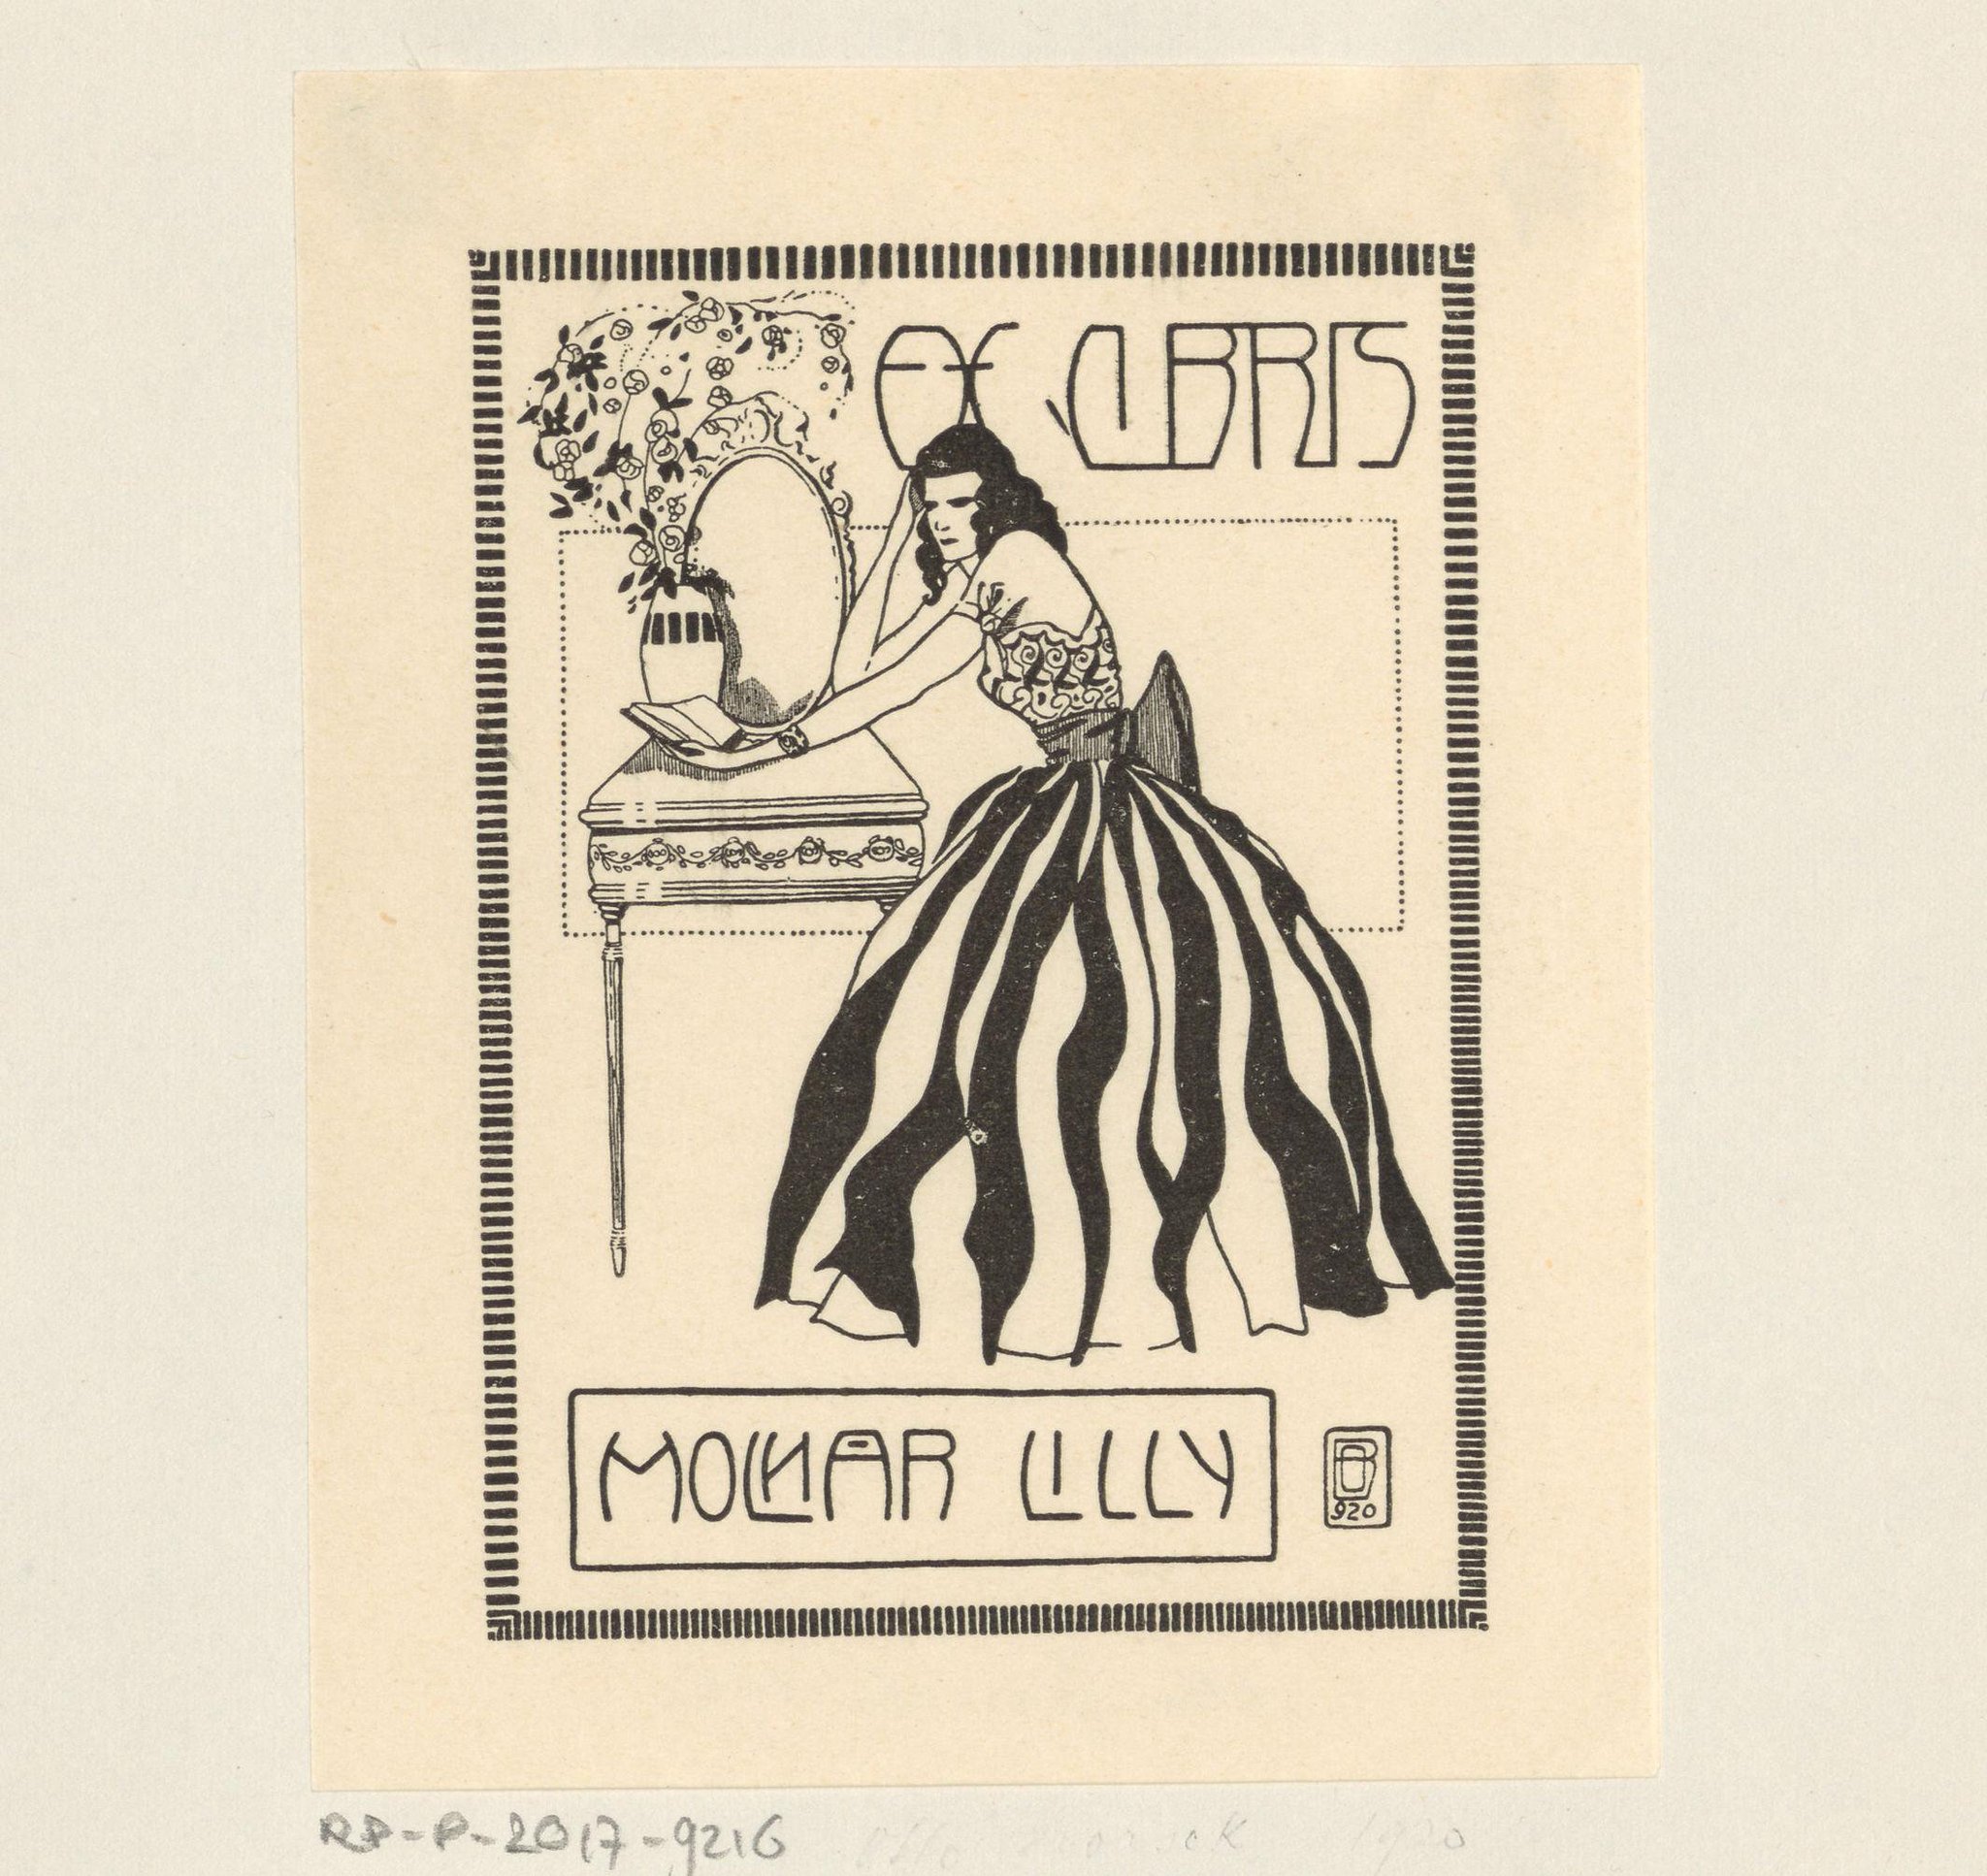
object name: bookplate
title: Ex libris Molhár Lilly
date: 1920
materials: paper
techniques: printing block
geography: czech republic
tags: reading, sitting figure - aa - female human figure, dress, gown: ball gown